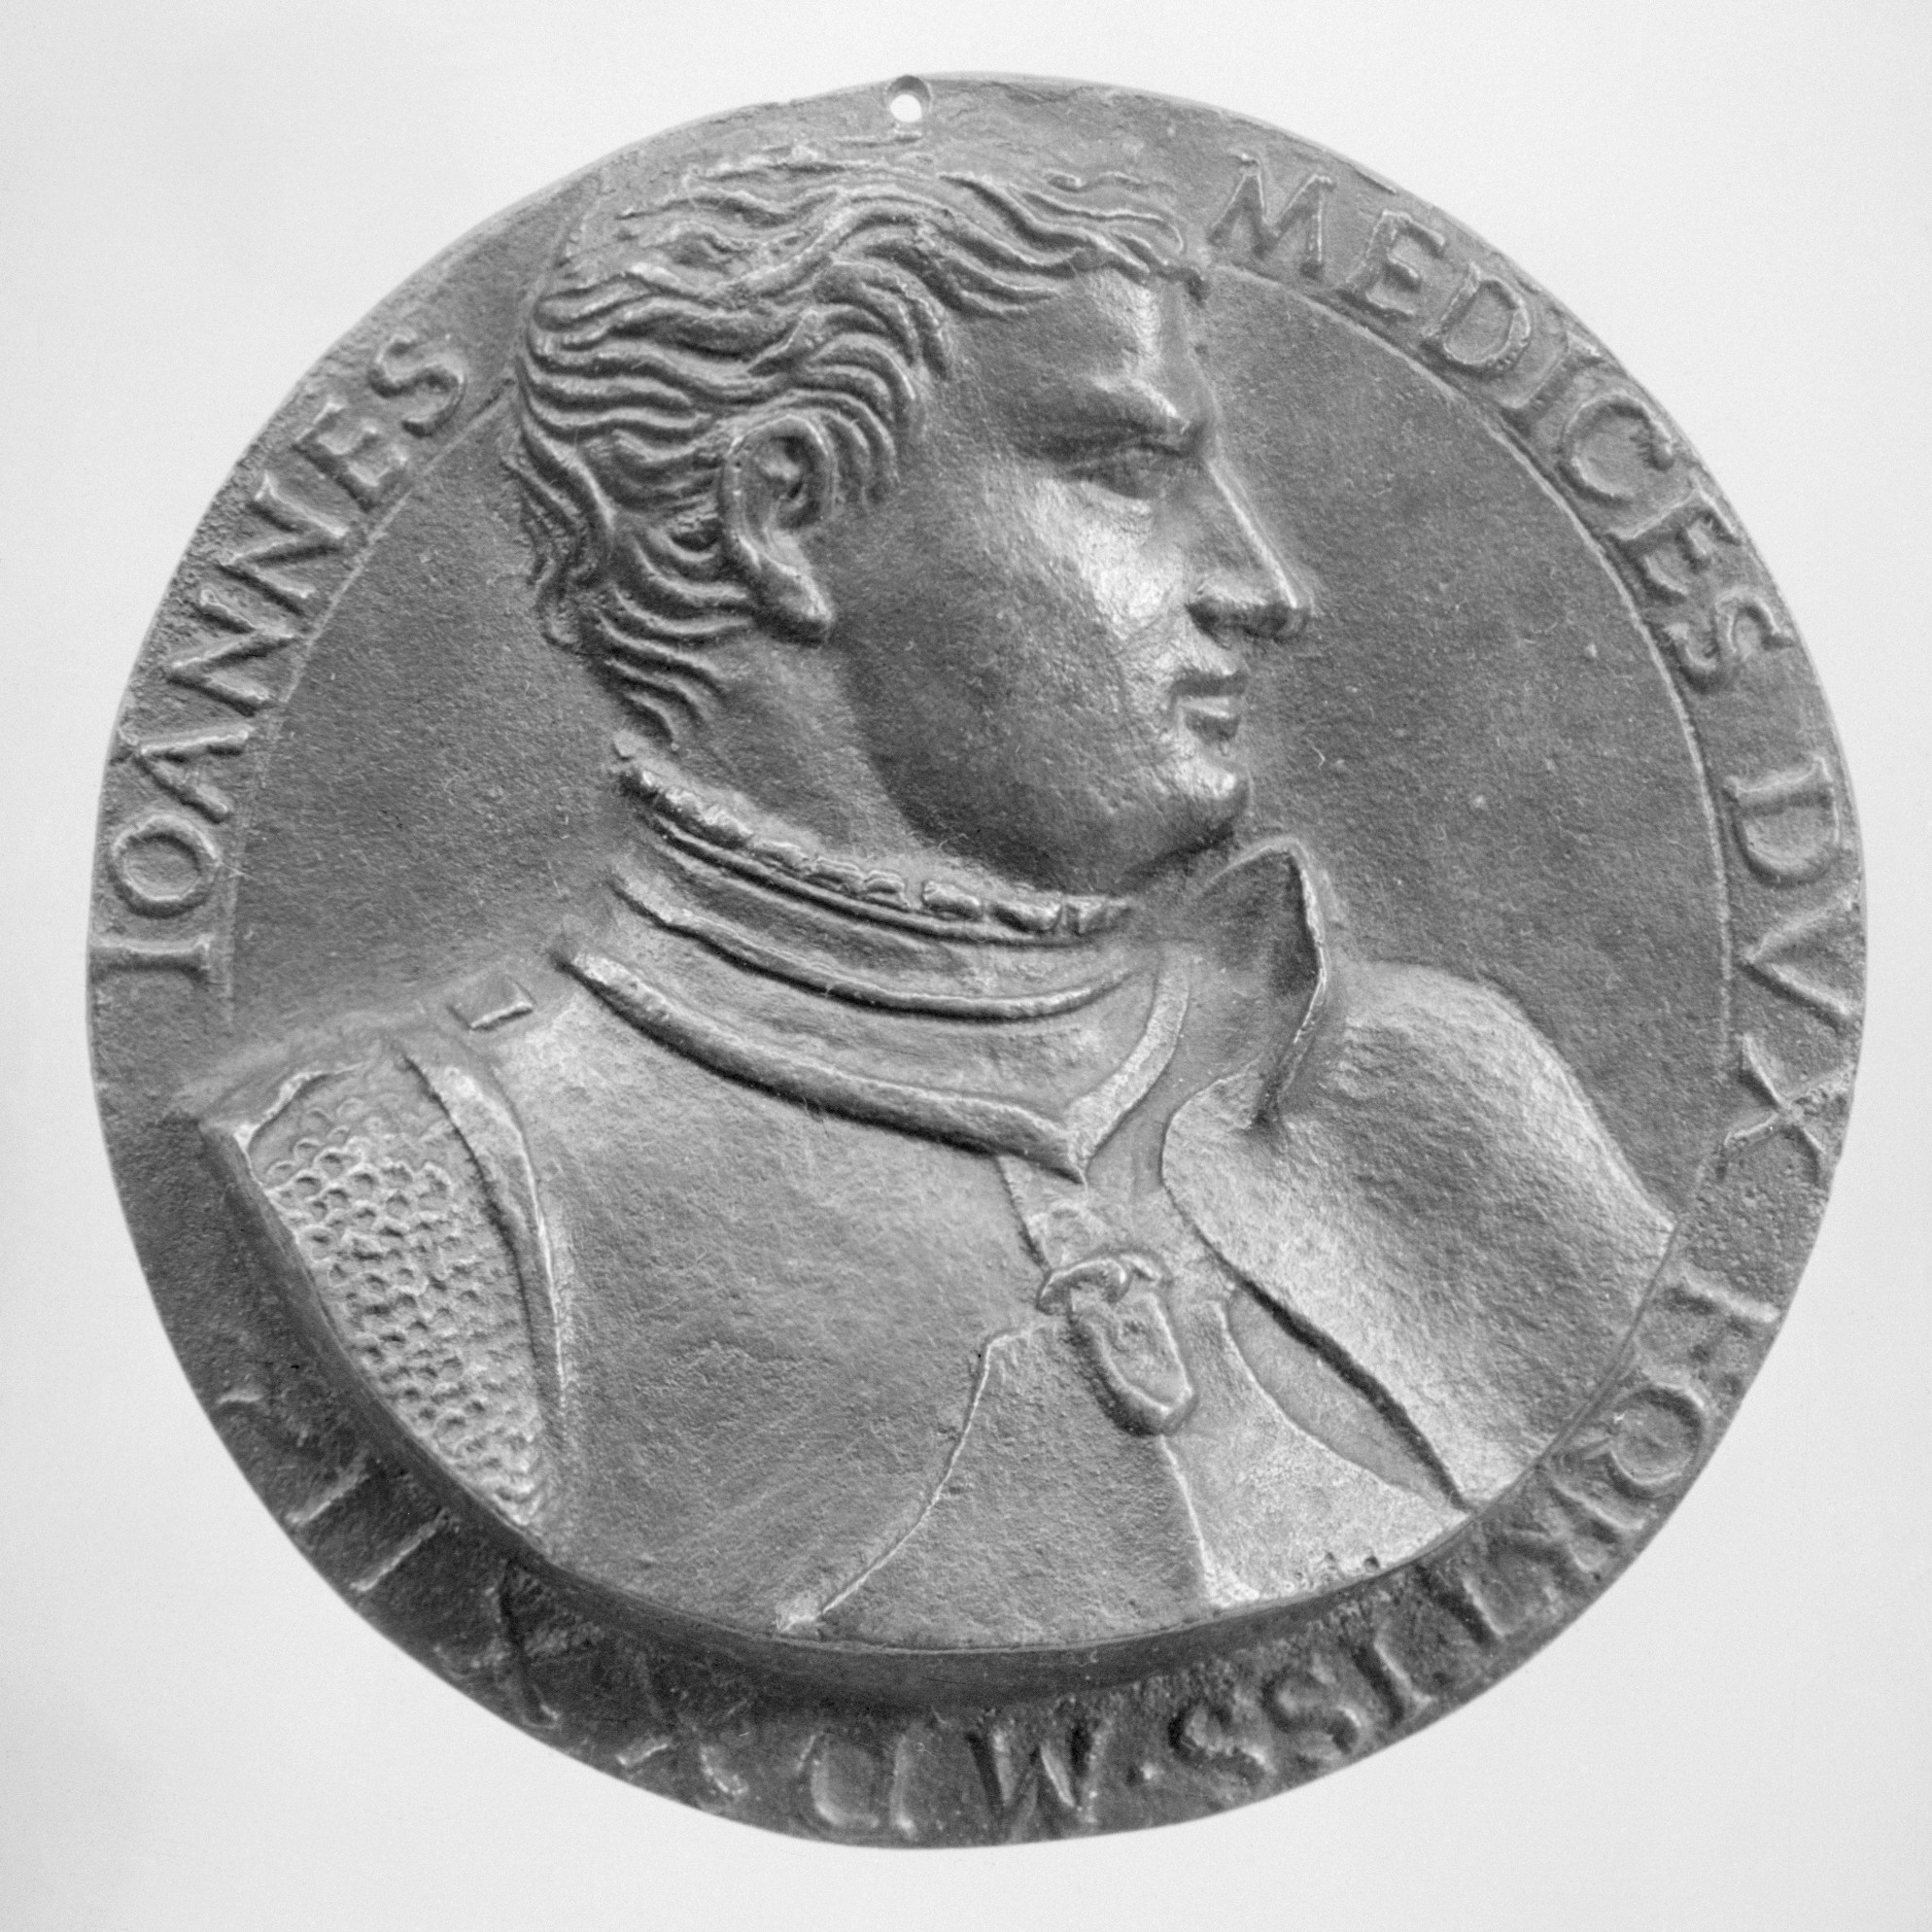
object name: medal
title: Giovanni de'Medici della Bande Nere (1498–1526), a Celebrated Condottiere, and Father of Cosimo I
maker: francesco da sangallo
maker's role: artist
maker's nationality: italian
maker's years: 1494-1576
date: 1570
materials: bronze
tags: men,profiles